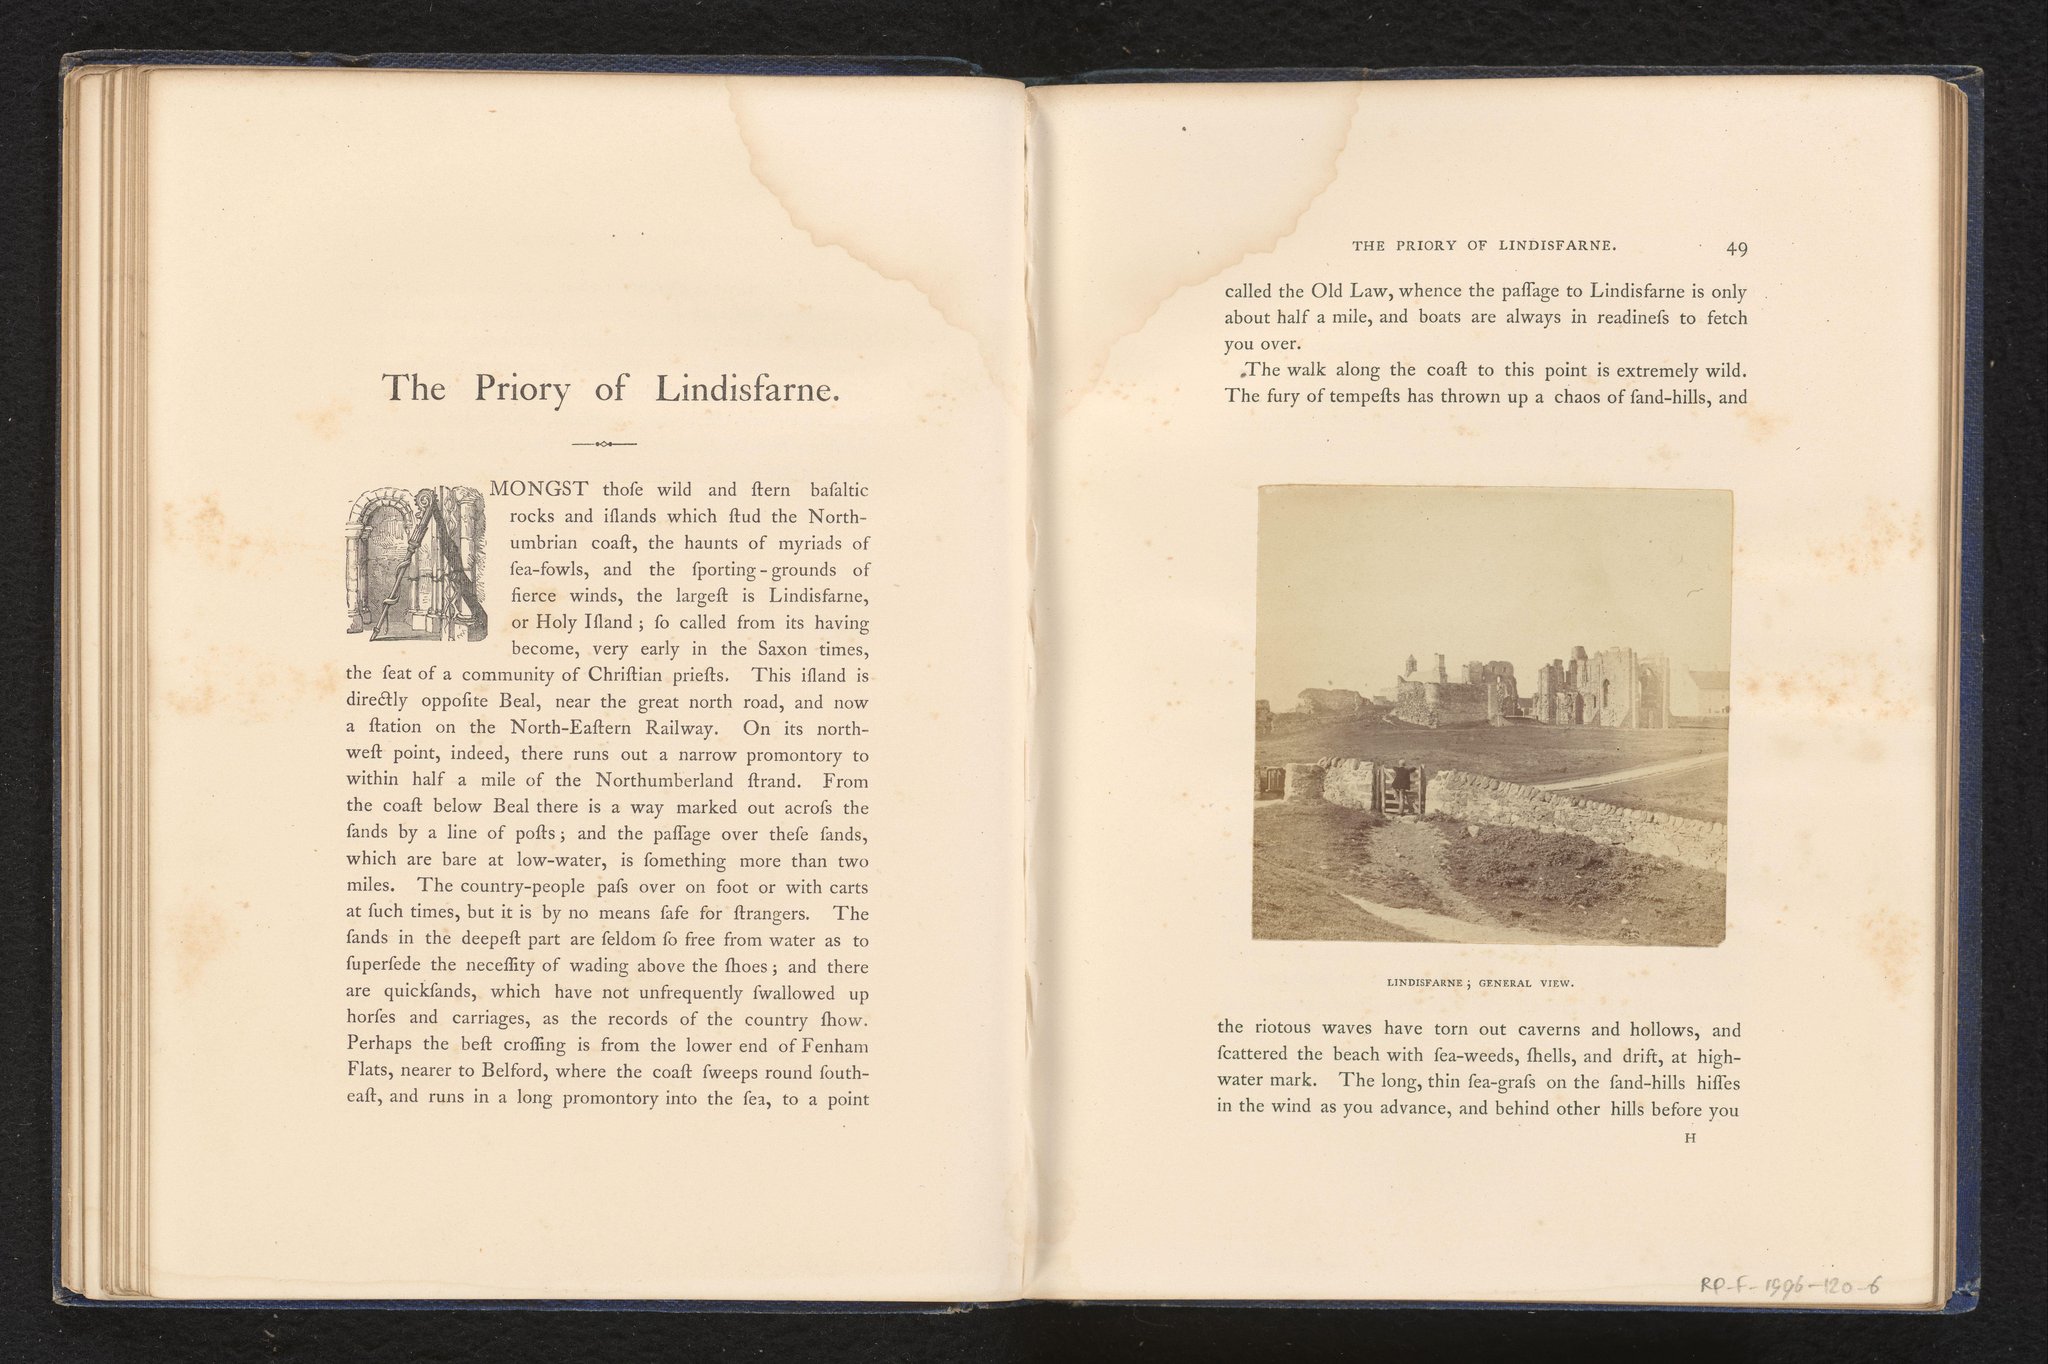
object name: page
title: Lindisfarne; General View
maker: stephen thompson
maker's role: fotograaf, schrijver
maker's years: 1831-1893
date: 1859-1864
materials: paper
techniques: albumen print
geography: lindisfarne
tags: ruin of a dwelling, house, castle, etc.